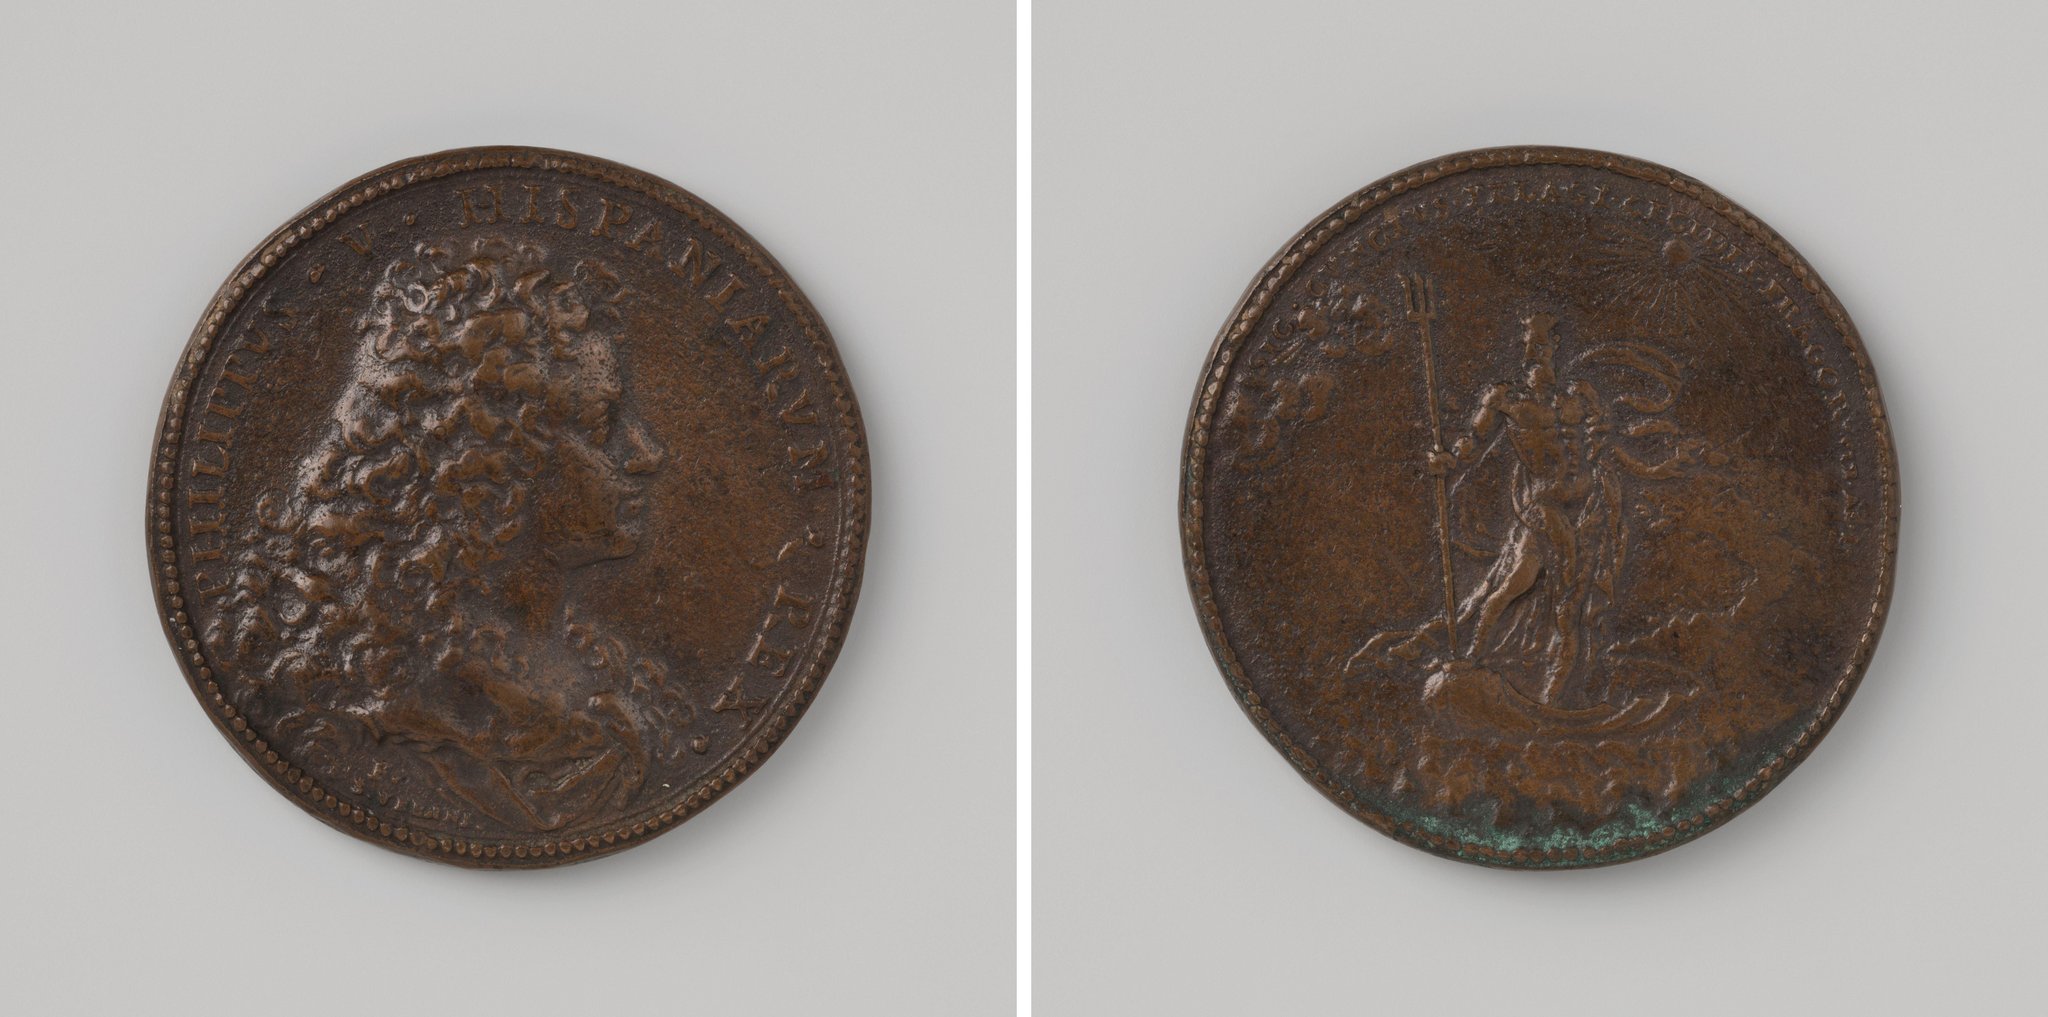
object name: history medal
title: Philips V Koning van Spanje na herstel van de rust in Napels 1700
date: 1700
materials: bronze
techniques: casting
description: Bronzen penning, op de voorzijde het borstbeeld van Philips naar rechts met omschrift, op de keerzijde Neptunus varend in een schelp, met omschrift.